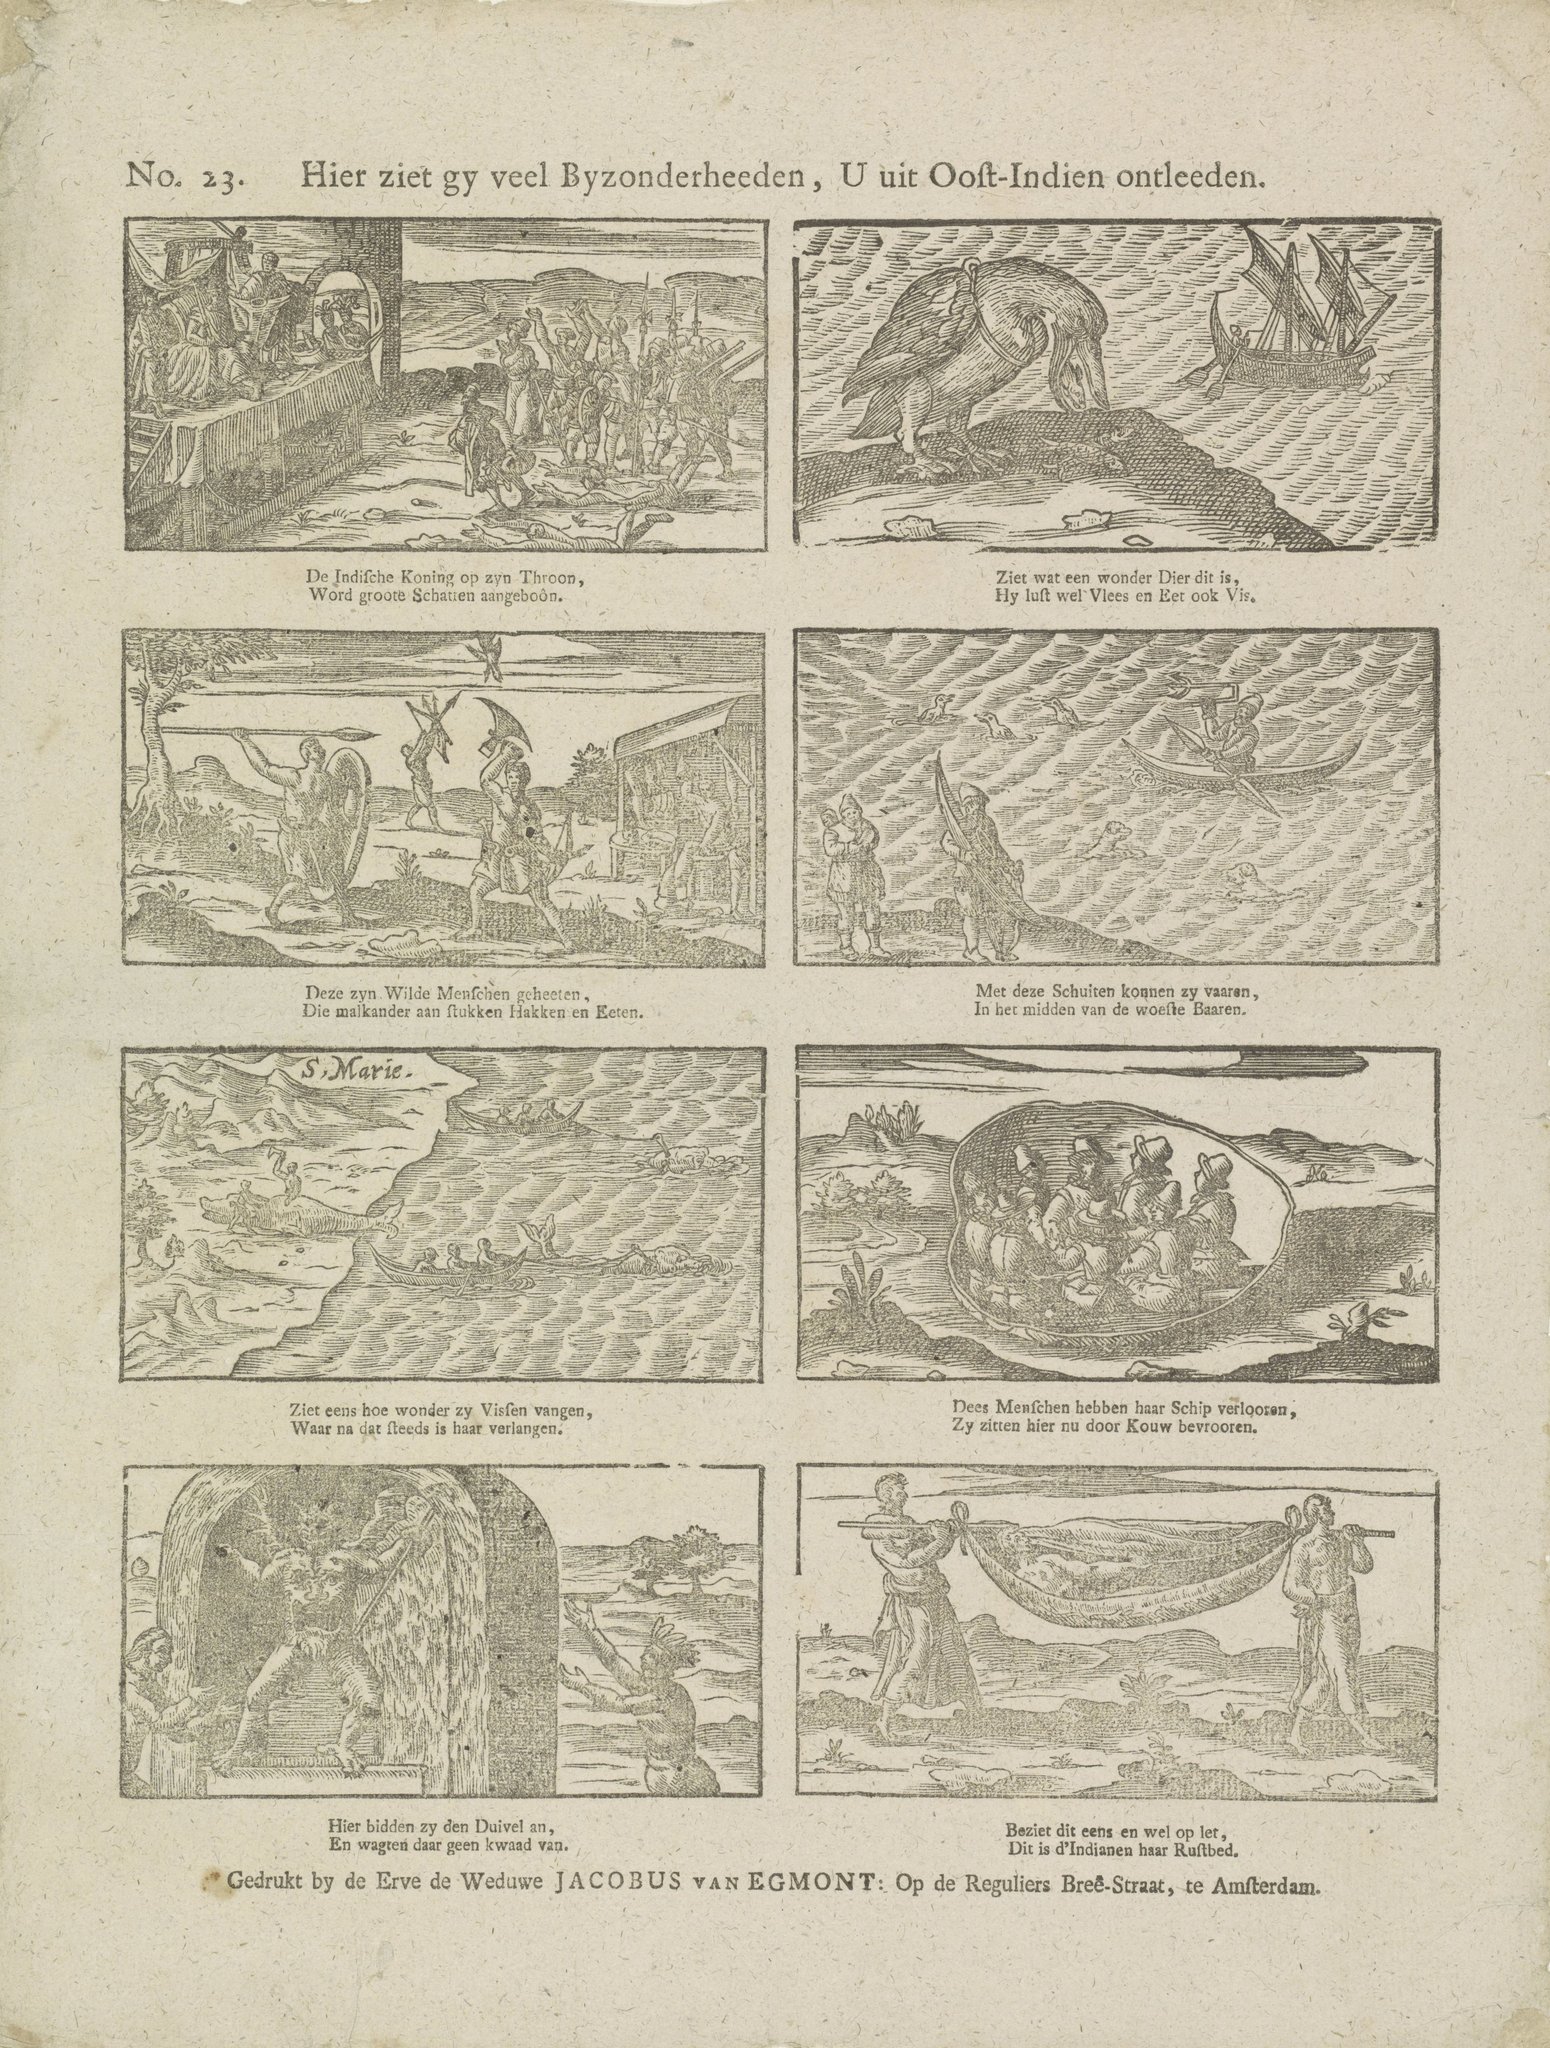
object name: print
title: Hier ziet gy veel byzonderheeden, U uit Oost-Indien ontleeden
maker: Anonymous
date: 1761-1804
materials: paper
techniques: letterpress printing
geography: amsterdam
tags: asiatic races and peoples, ruler, sovereign - bb - female ruler, sea and coastal fishery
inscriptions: collector's mark: Lugt 2760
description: Blad met 8 voorstellingen van taferelen uit Oost-Indië, waaronder de Indische koning op zijn troon, Indische dieren en Indische vissers. Onder elke afbeelding een tweeregelig vers. Genummerd linksboven: No. 23.